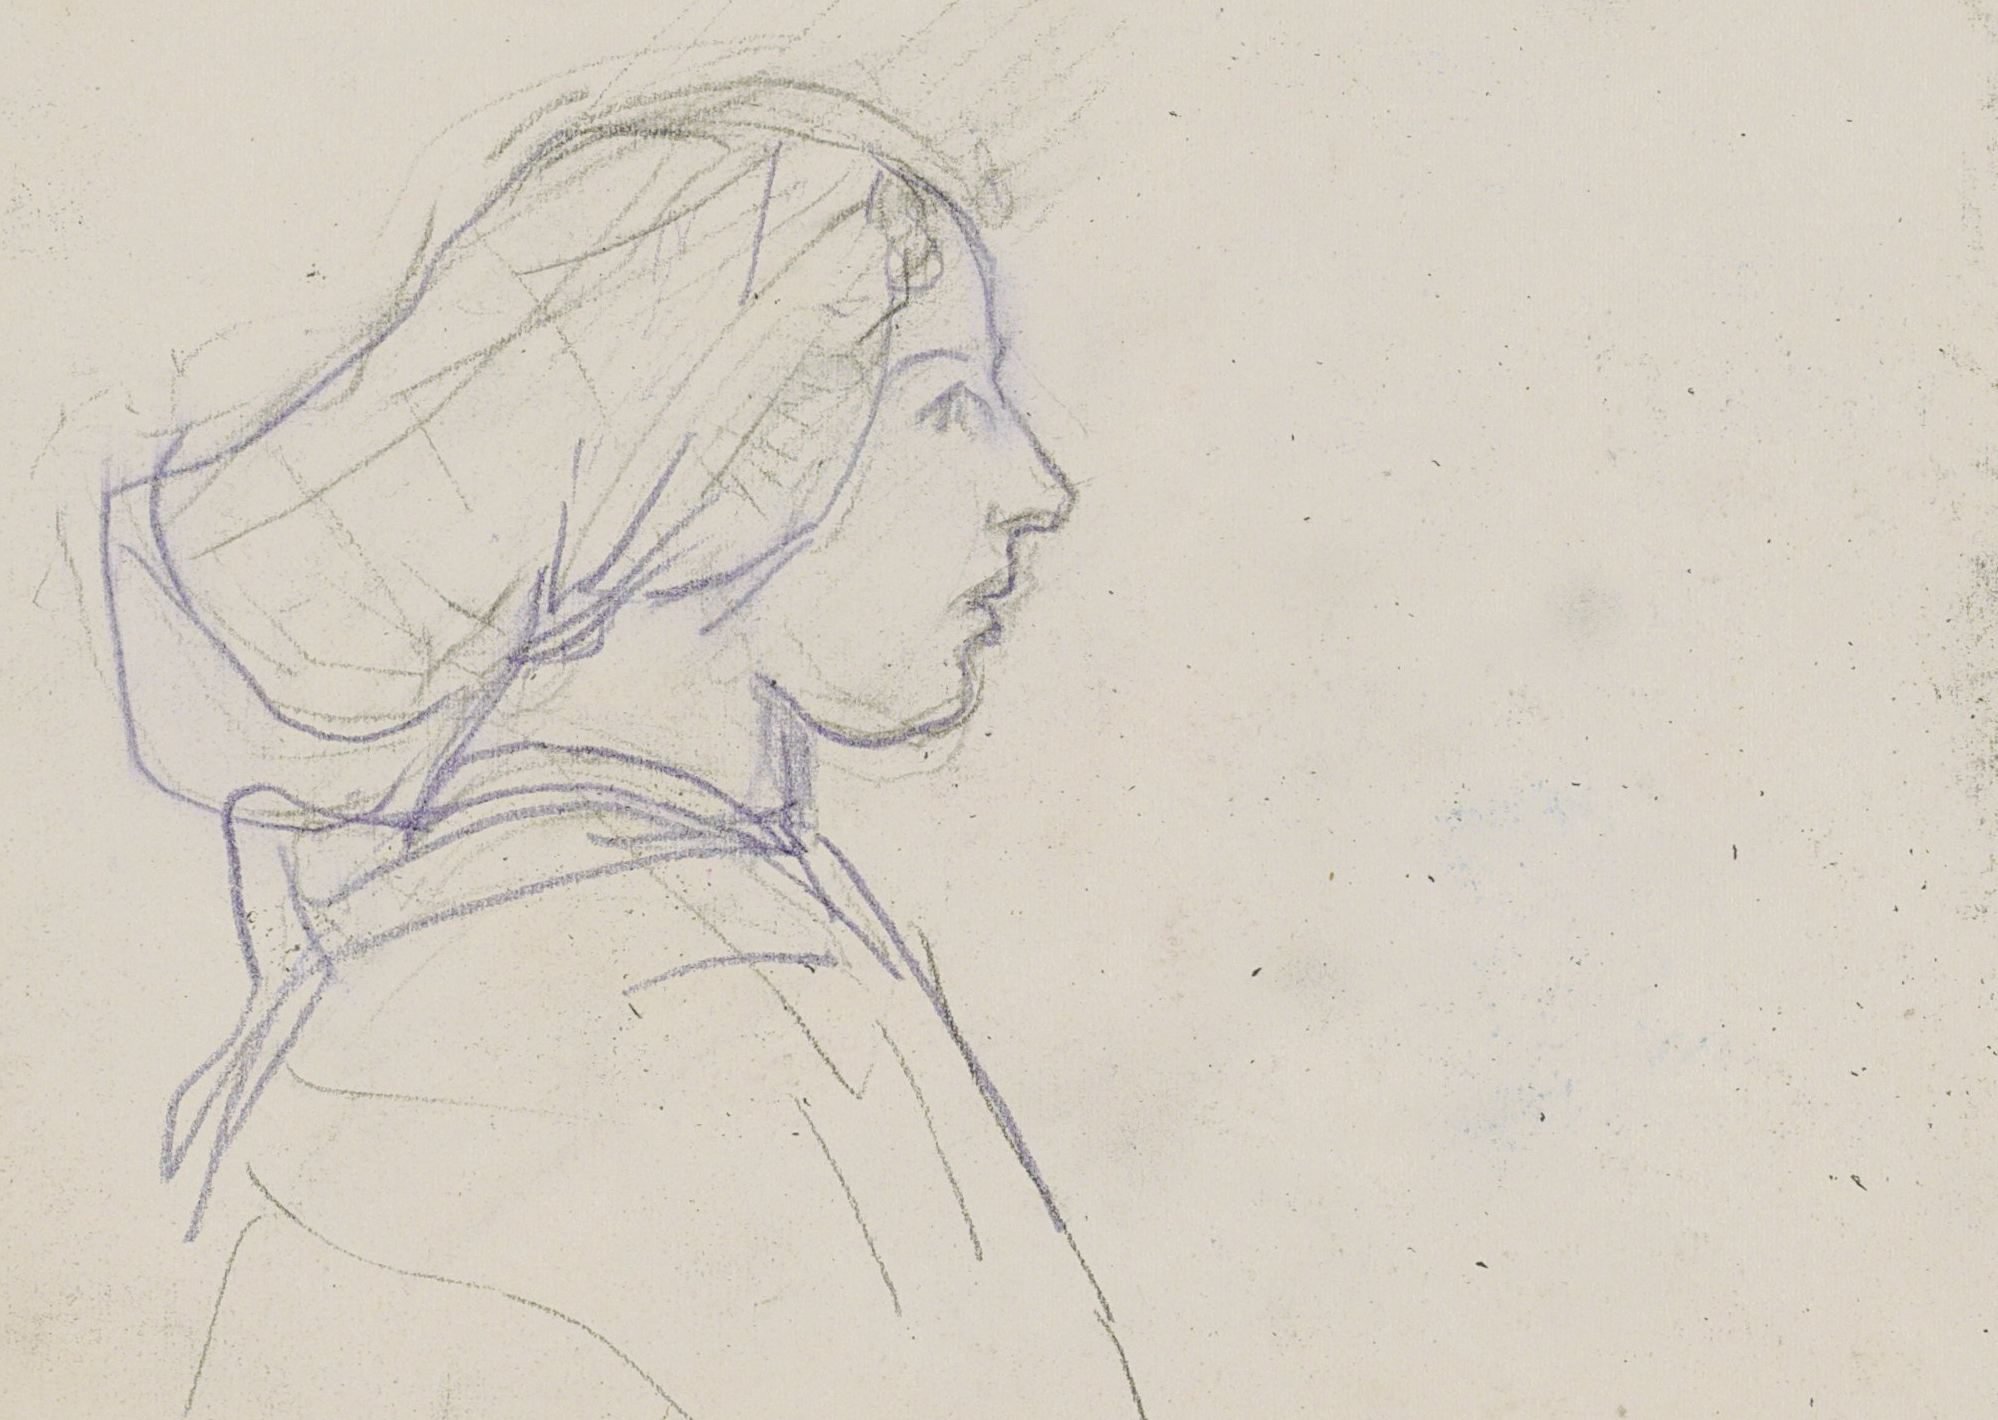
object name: sketchbook leaf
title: Vrouw in Scheveningse klederdracht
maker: johan antonie de jonge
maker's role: draughtsman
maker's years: 1864-1927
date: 1881-1927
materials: chalk, paper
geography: scheveningen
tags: folk costume, regional costume (+ women's clothes), adult woman (+ sideview, profile)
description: Vrouw in Scheveningse klederdracht, in profiel naar rechts. Blad 26 recto uit een schetsboek met 28 bladen.